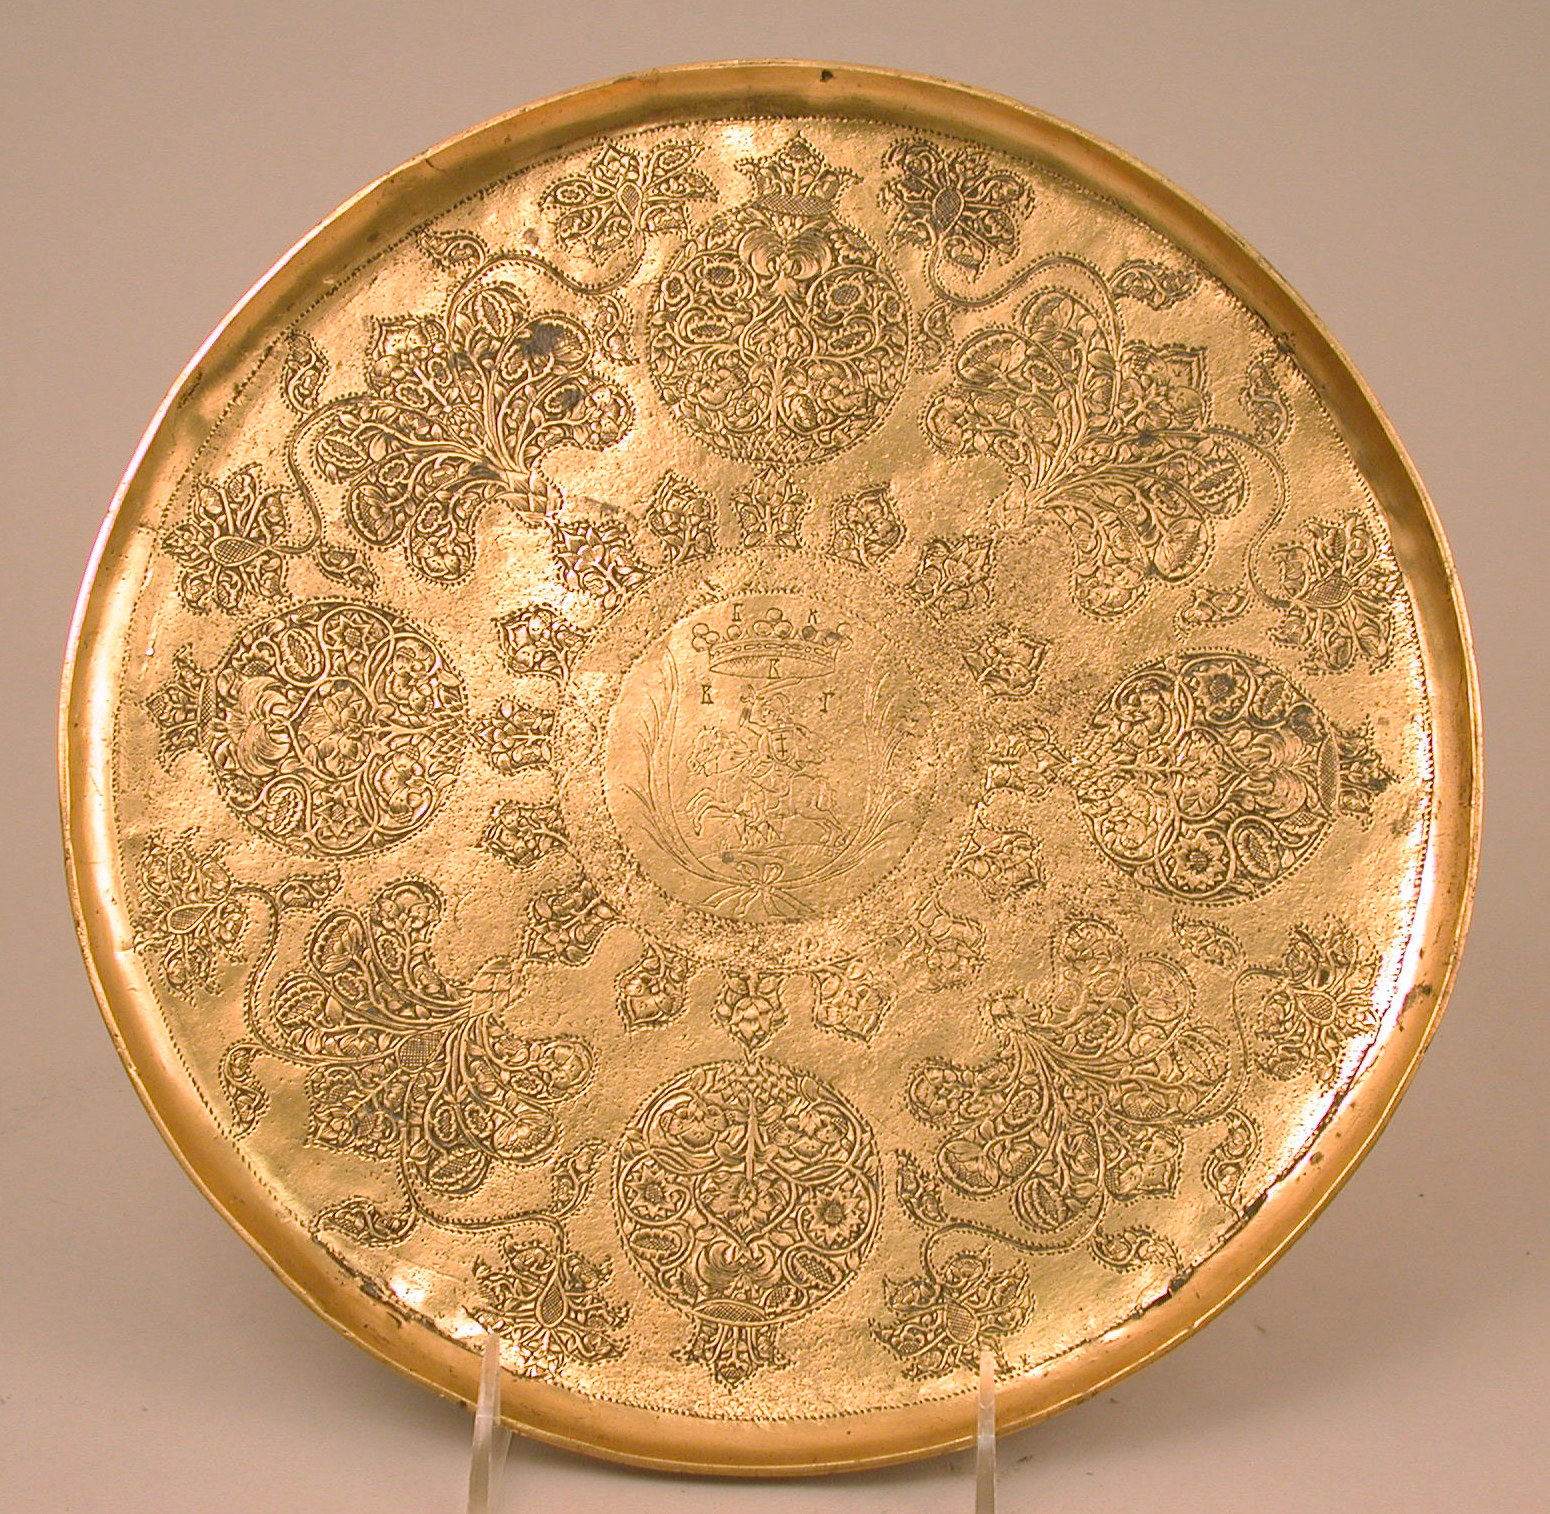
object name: plate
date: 1801-1900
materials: metal, silver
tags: shields,swords,horses,flowers